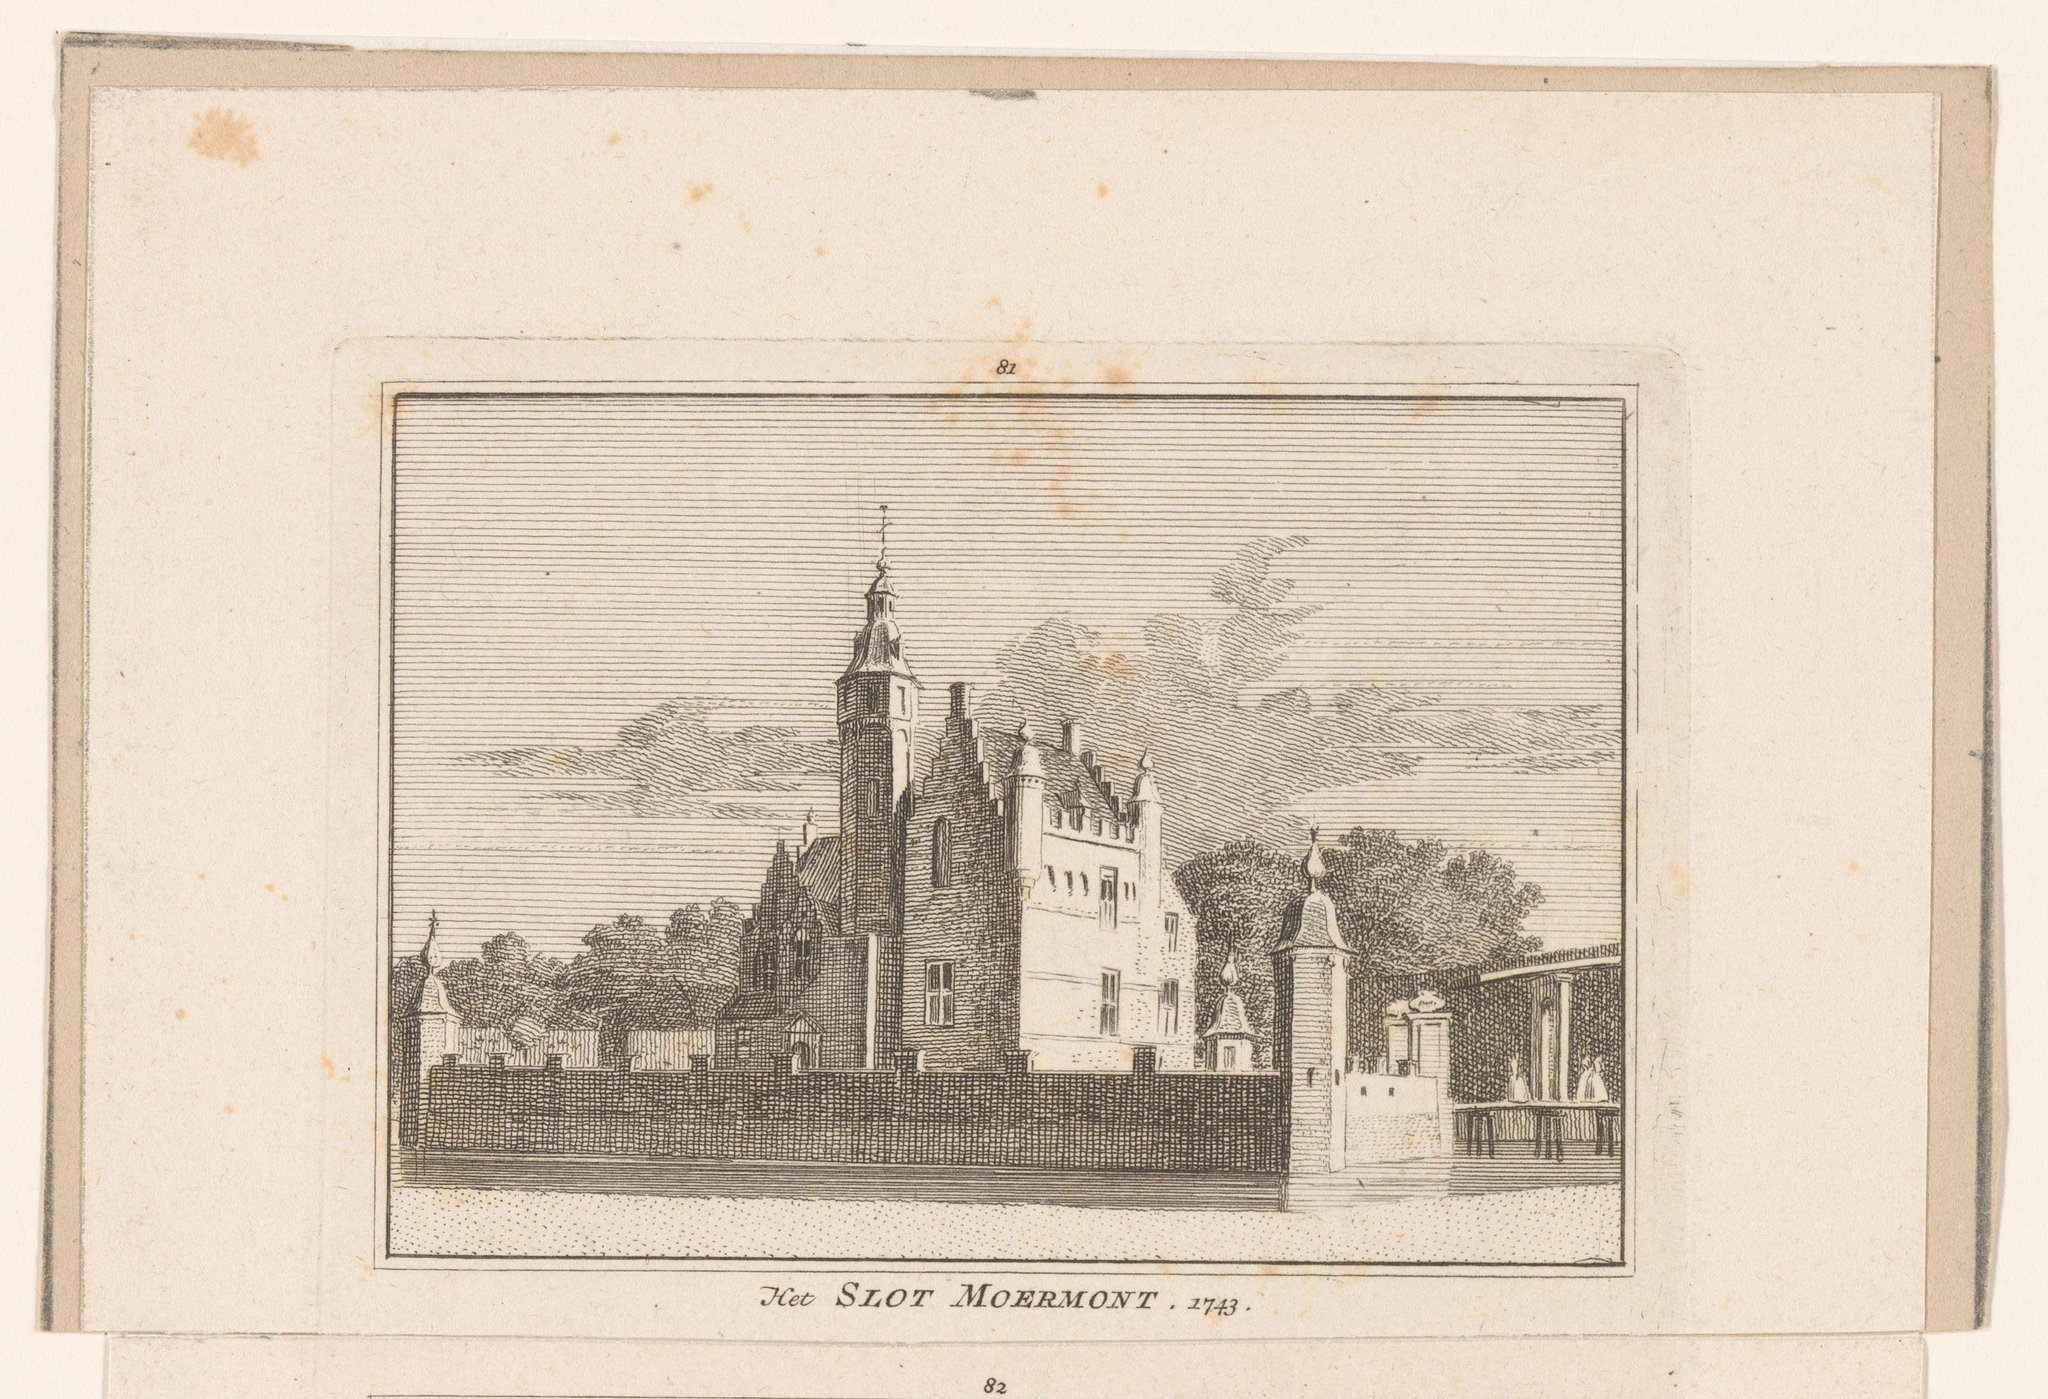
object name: print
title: Gezicht op Slot Moermond, 1743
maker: hendrik spilman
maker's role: draughtsman, painter, print maker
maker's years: 1721-1784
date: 1754-1792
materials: paper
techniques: etching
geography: haarlem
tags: castle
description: Prent ook gebruikt in: Het verheerlykt Nederland of kabinet van hedendaagsche gezigten van steden, dorpen (…). 9 delen. Amsterdam: Isaak Tirion en weduwe Isaak Tirion, 1745-1774, dl. 5 (1754), ill. 81. Of in: Nederlandsche tafereelen; of eene keurige verzameling van negen honderd fraaije gezigten van steden, dorpen, sloten, oudheden [….]. 9 delen. Amsterdam: Jan de Groot, 1792, dl. 5, ill. 81.